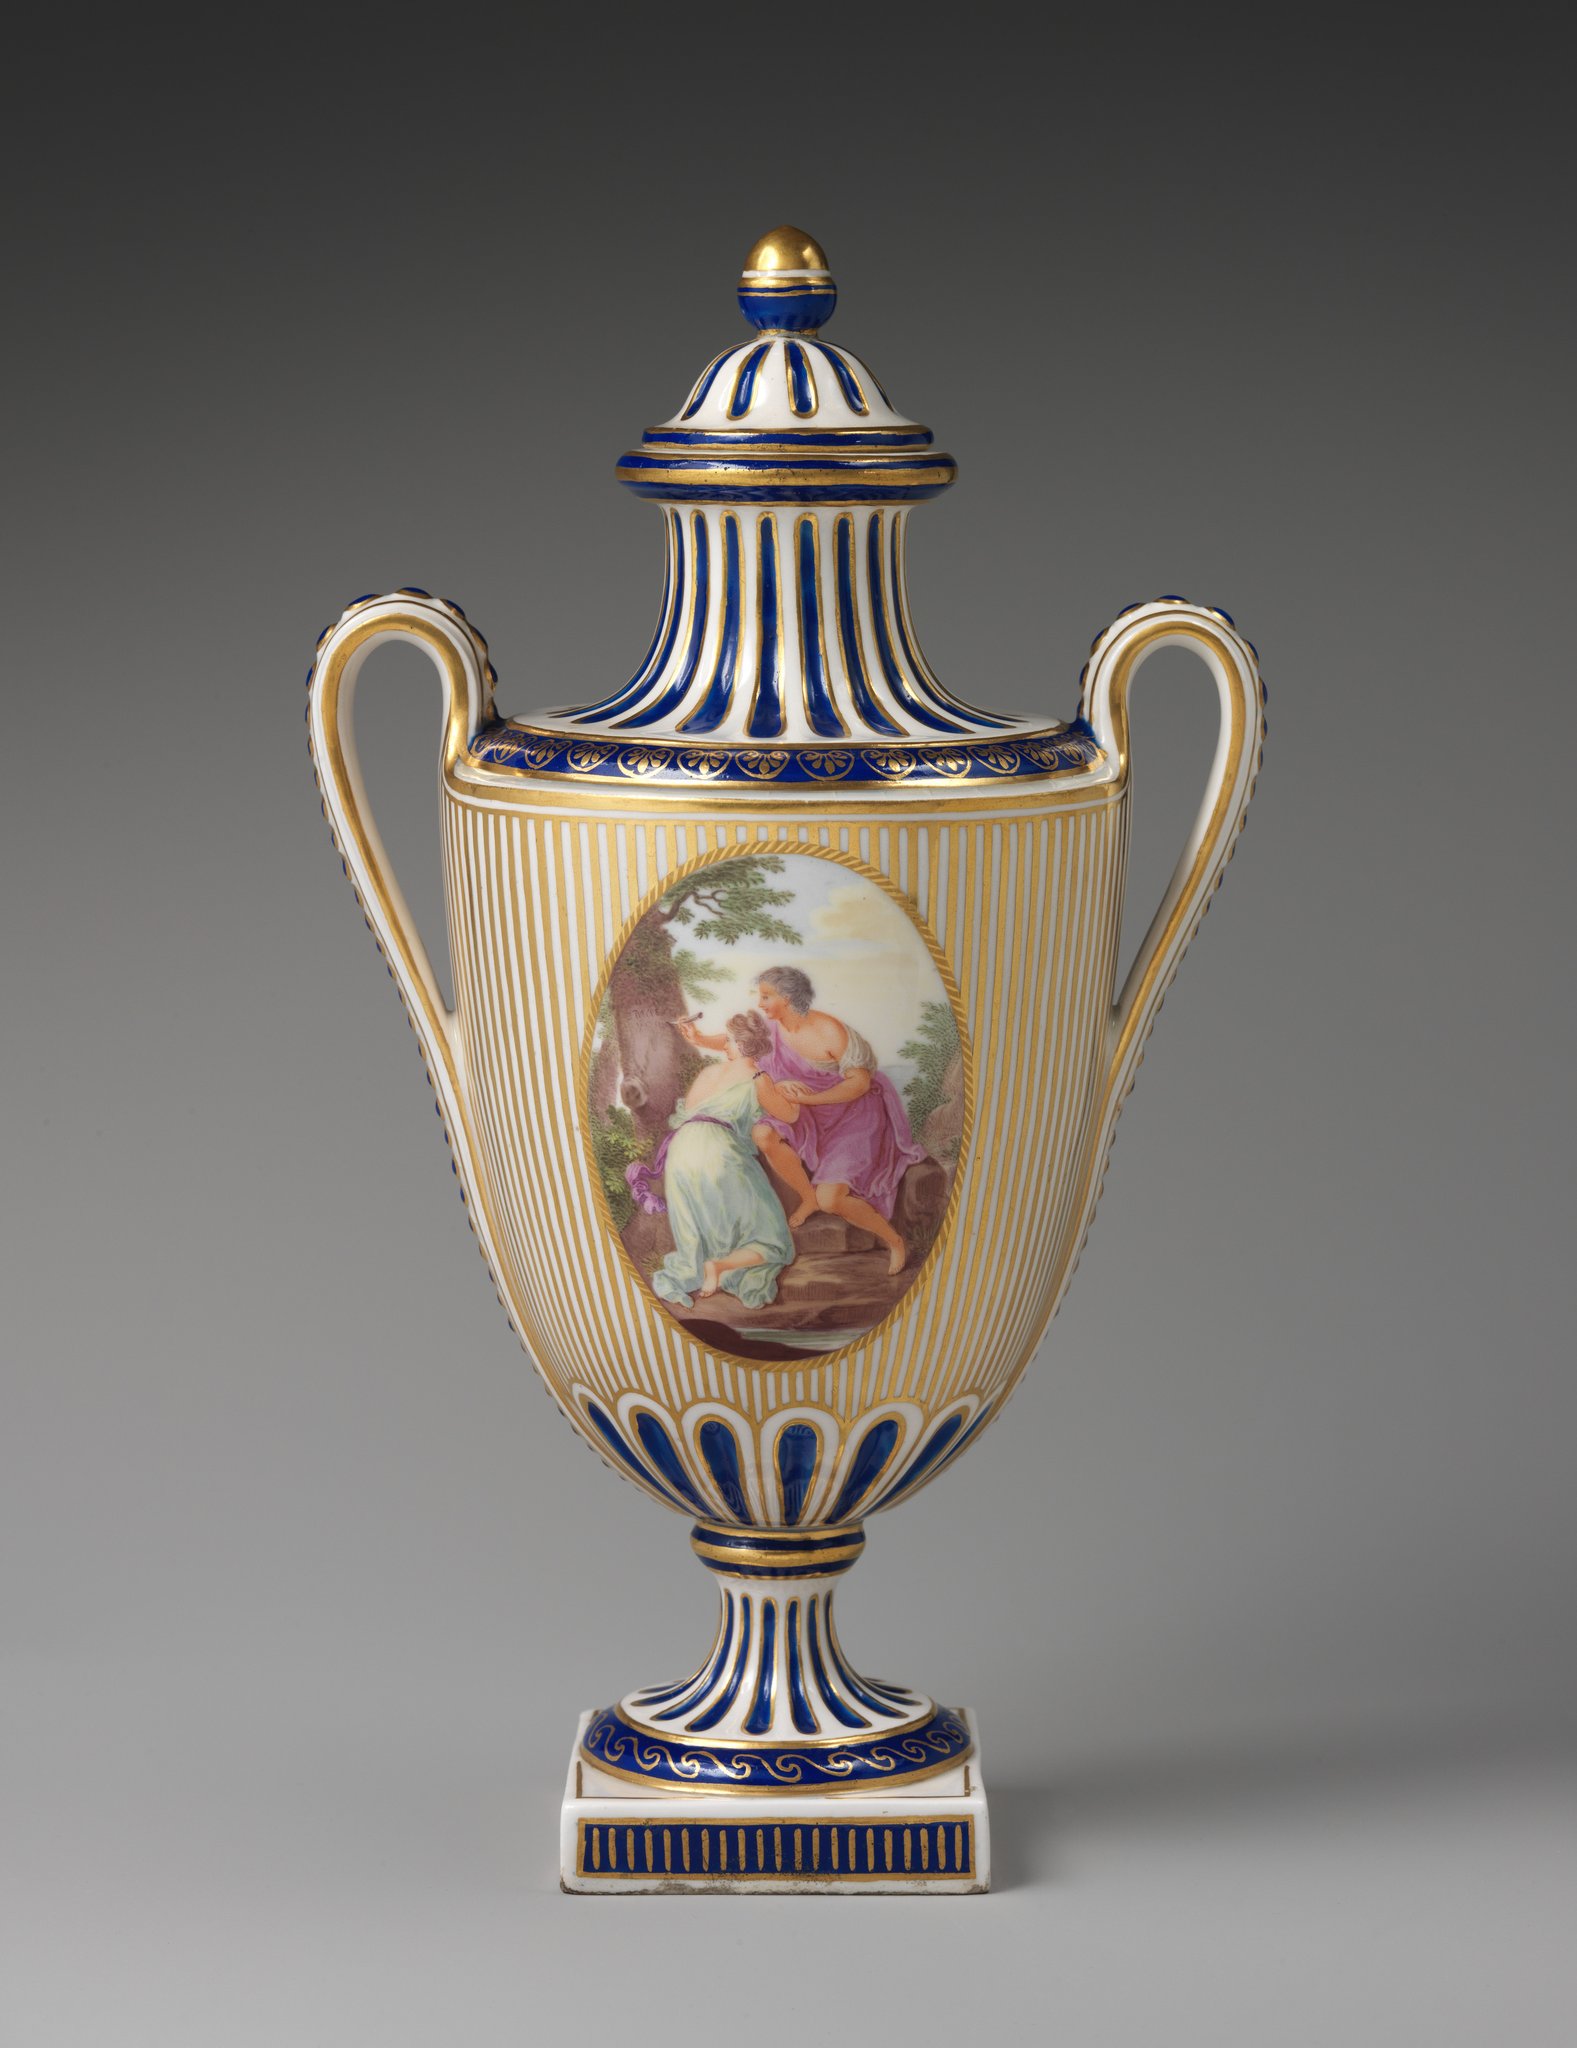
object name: vase with cover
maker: derby porcelain manufactory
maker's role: manufactory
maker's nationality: british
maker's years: 1751-1785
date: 1775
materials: soft paste porcelain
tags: men,women